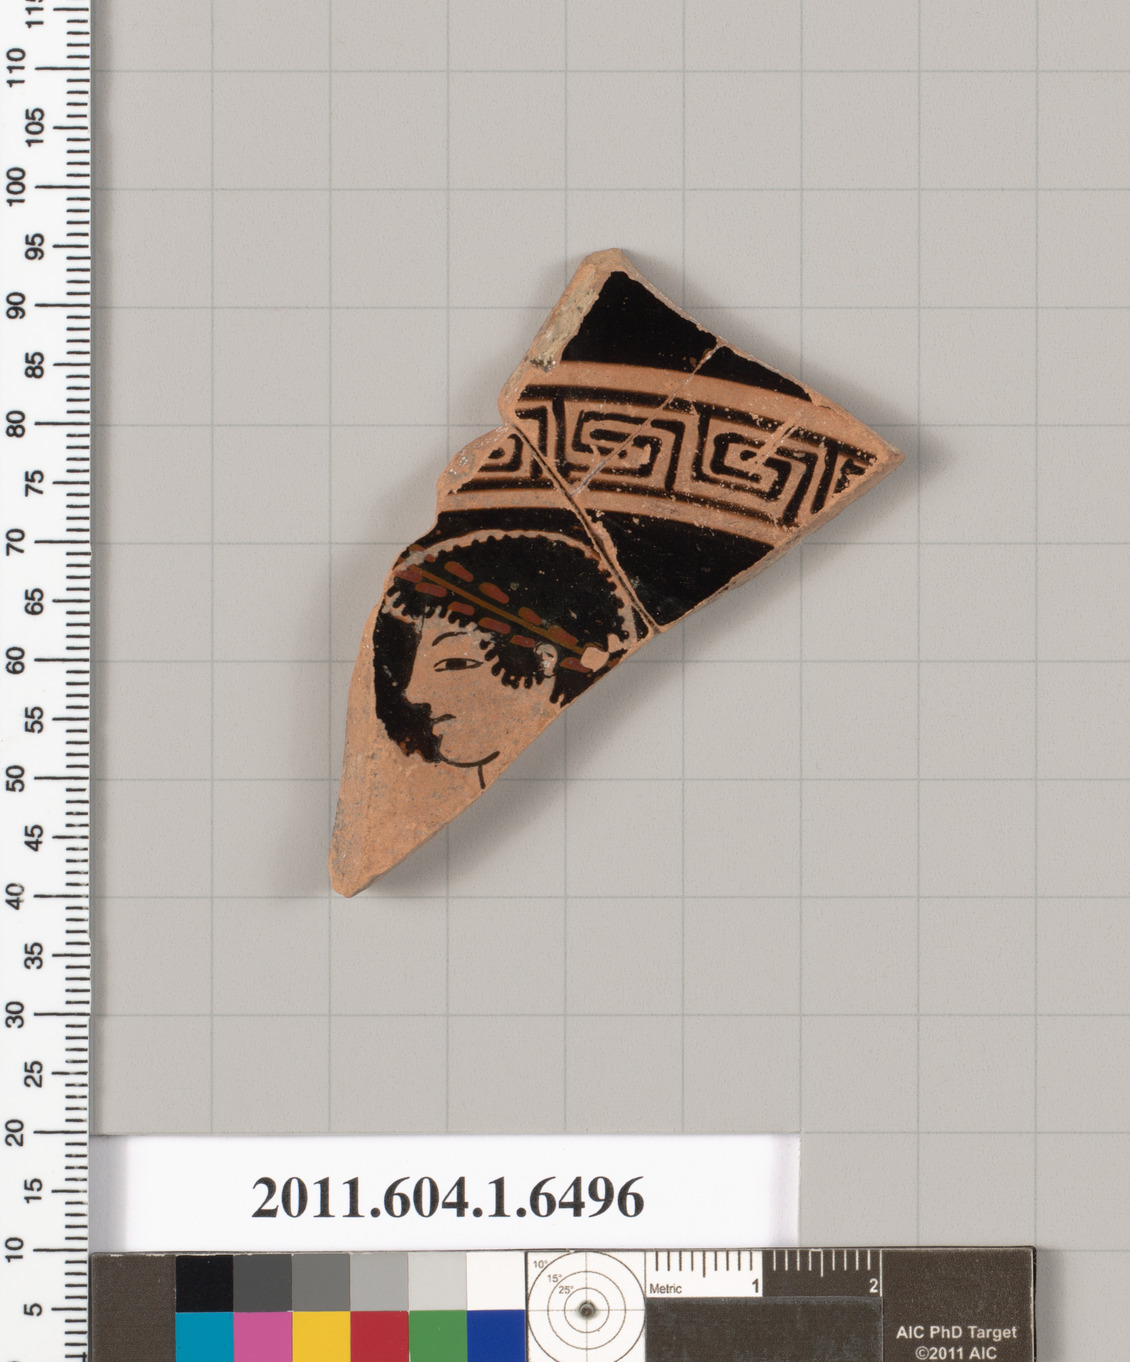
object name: kylix fragment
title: Terracotta fragment of a kylix (drinking cup)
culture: greek, attic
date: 490-480 BCE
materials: terracotta